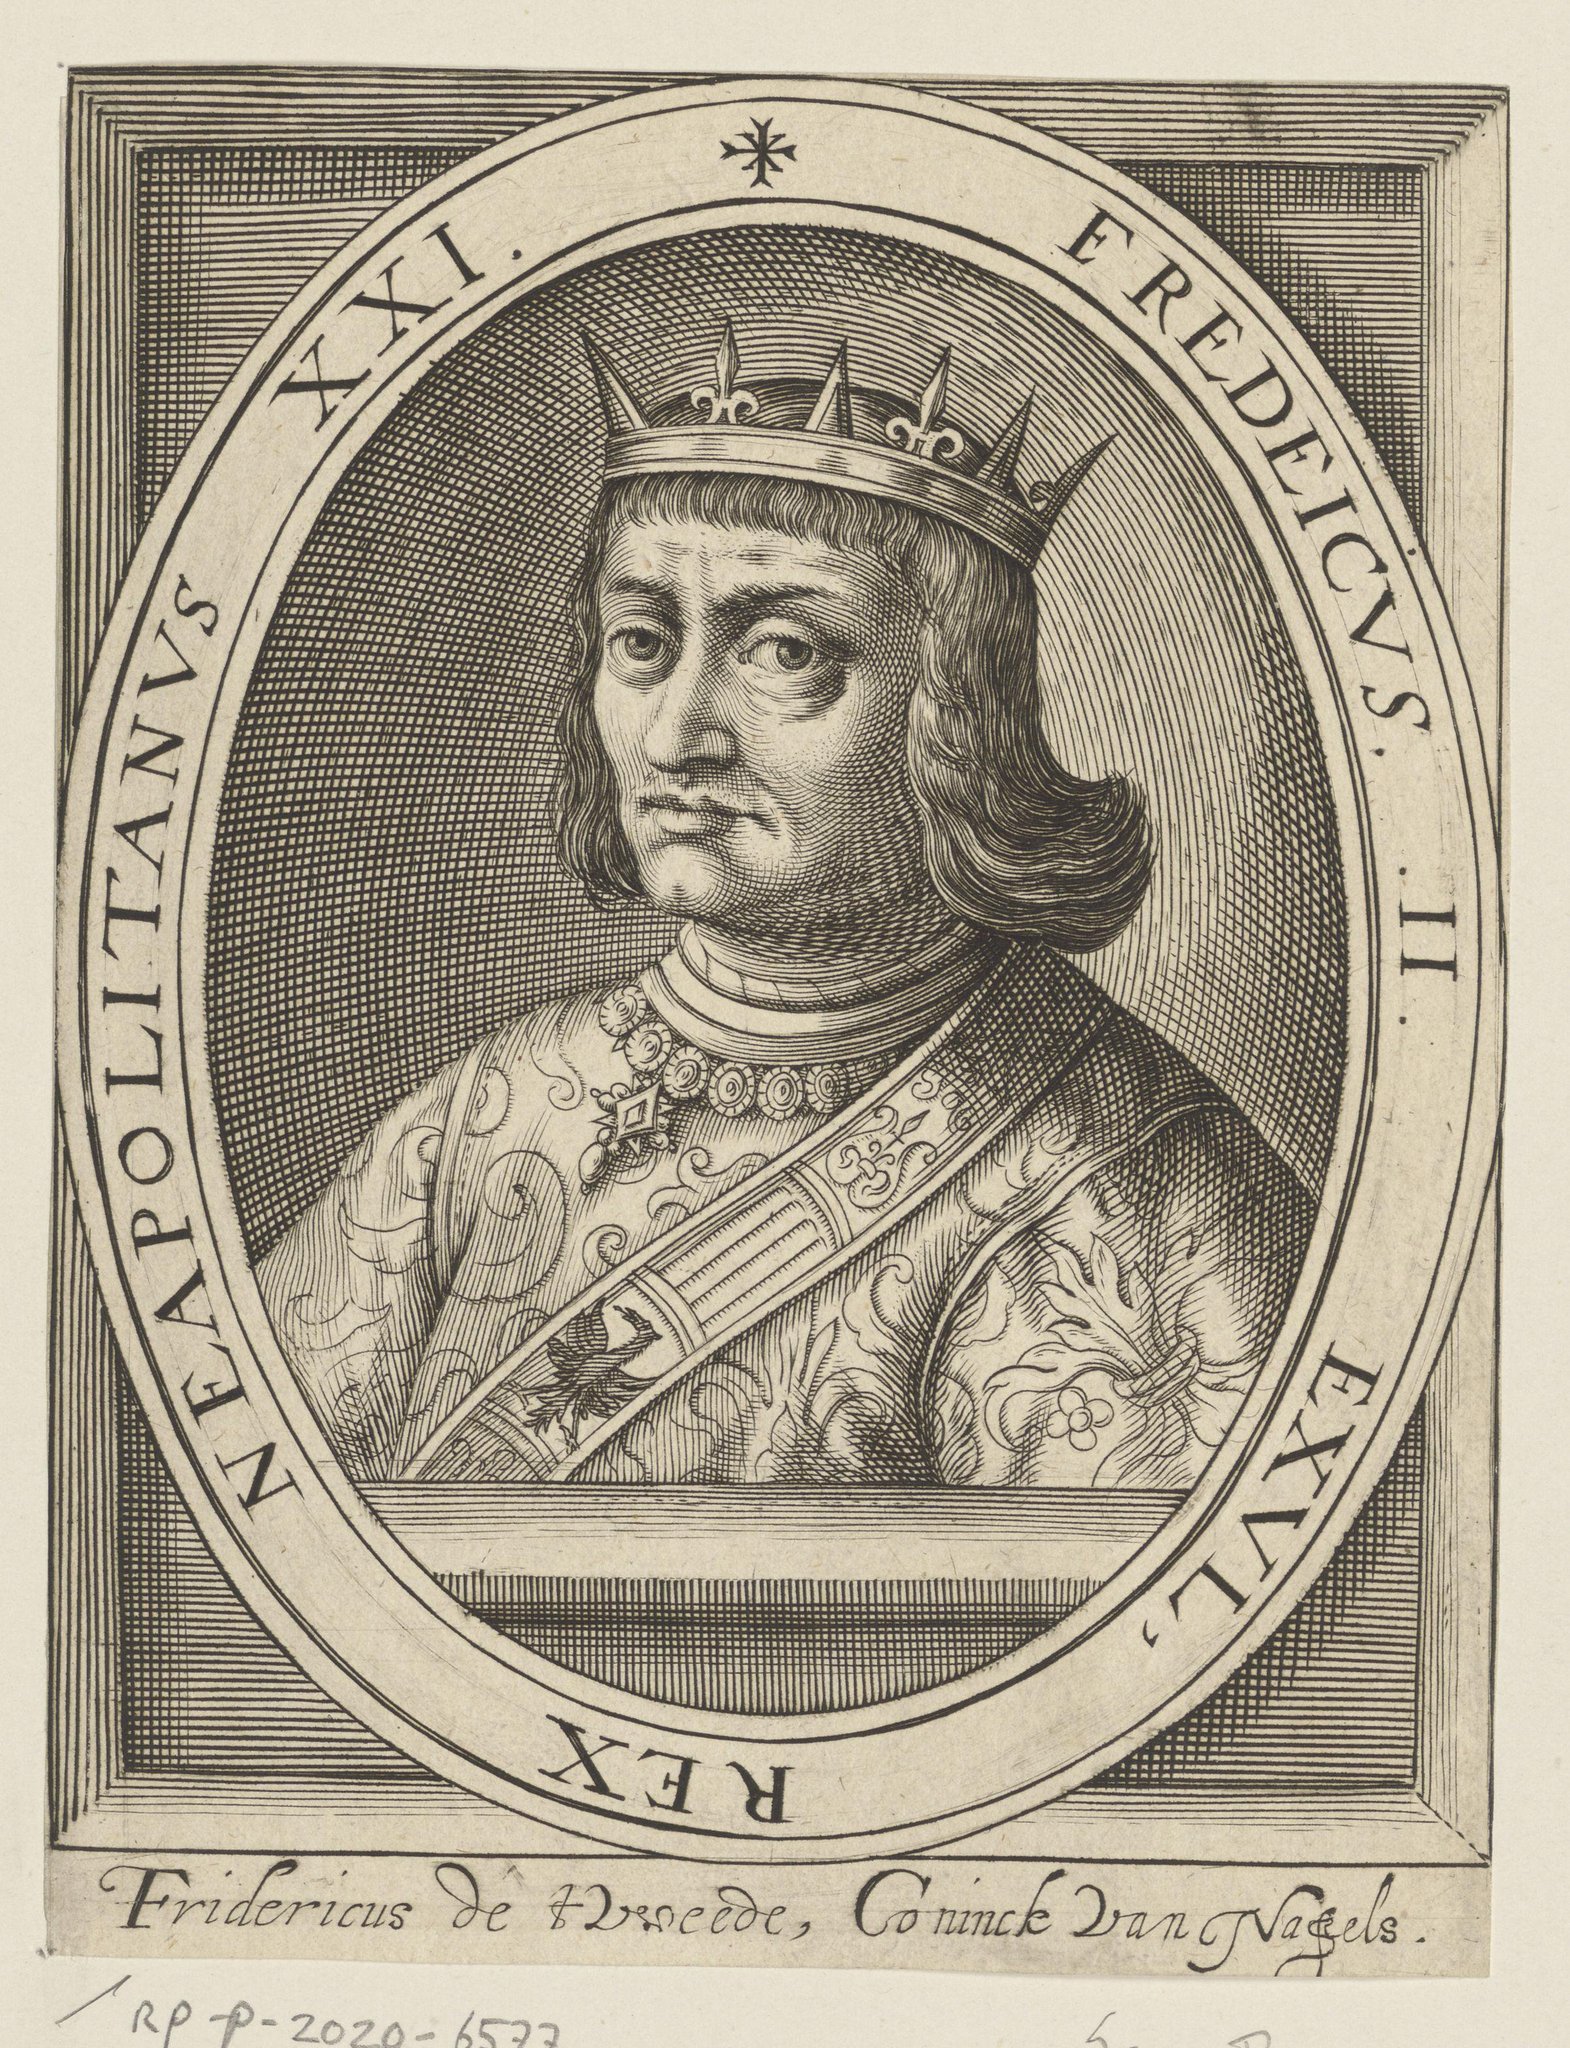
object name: print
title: Portret van Frederik II van Aragon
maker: Anonymous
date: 1615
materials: paper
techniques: engraving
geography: northern netherlands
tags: crown (symbol of sovereignty), historical persons, king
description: Prent met tekst in boekdruk op verso gebruikt in: Clerck, Nicolaes de. Tooneel der keyseren en coningen van Christenryck sedert den onderganck van het Griecks keyserdom. Arnhem: Jan Jansz., 1615.